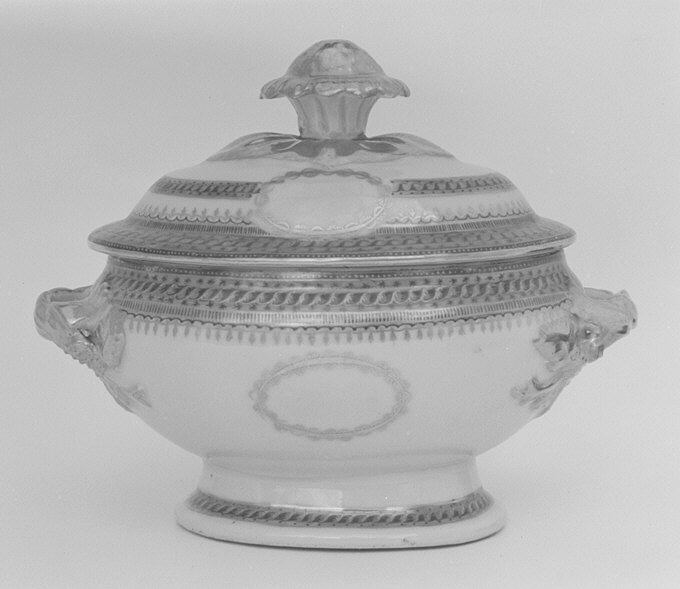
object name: dish with cover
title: Dish with cover (part of a service)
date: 1785-1800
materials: hard paste porcelain